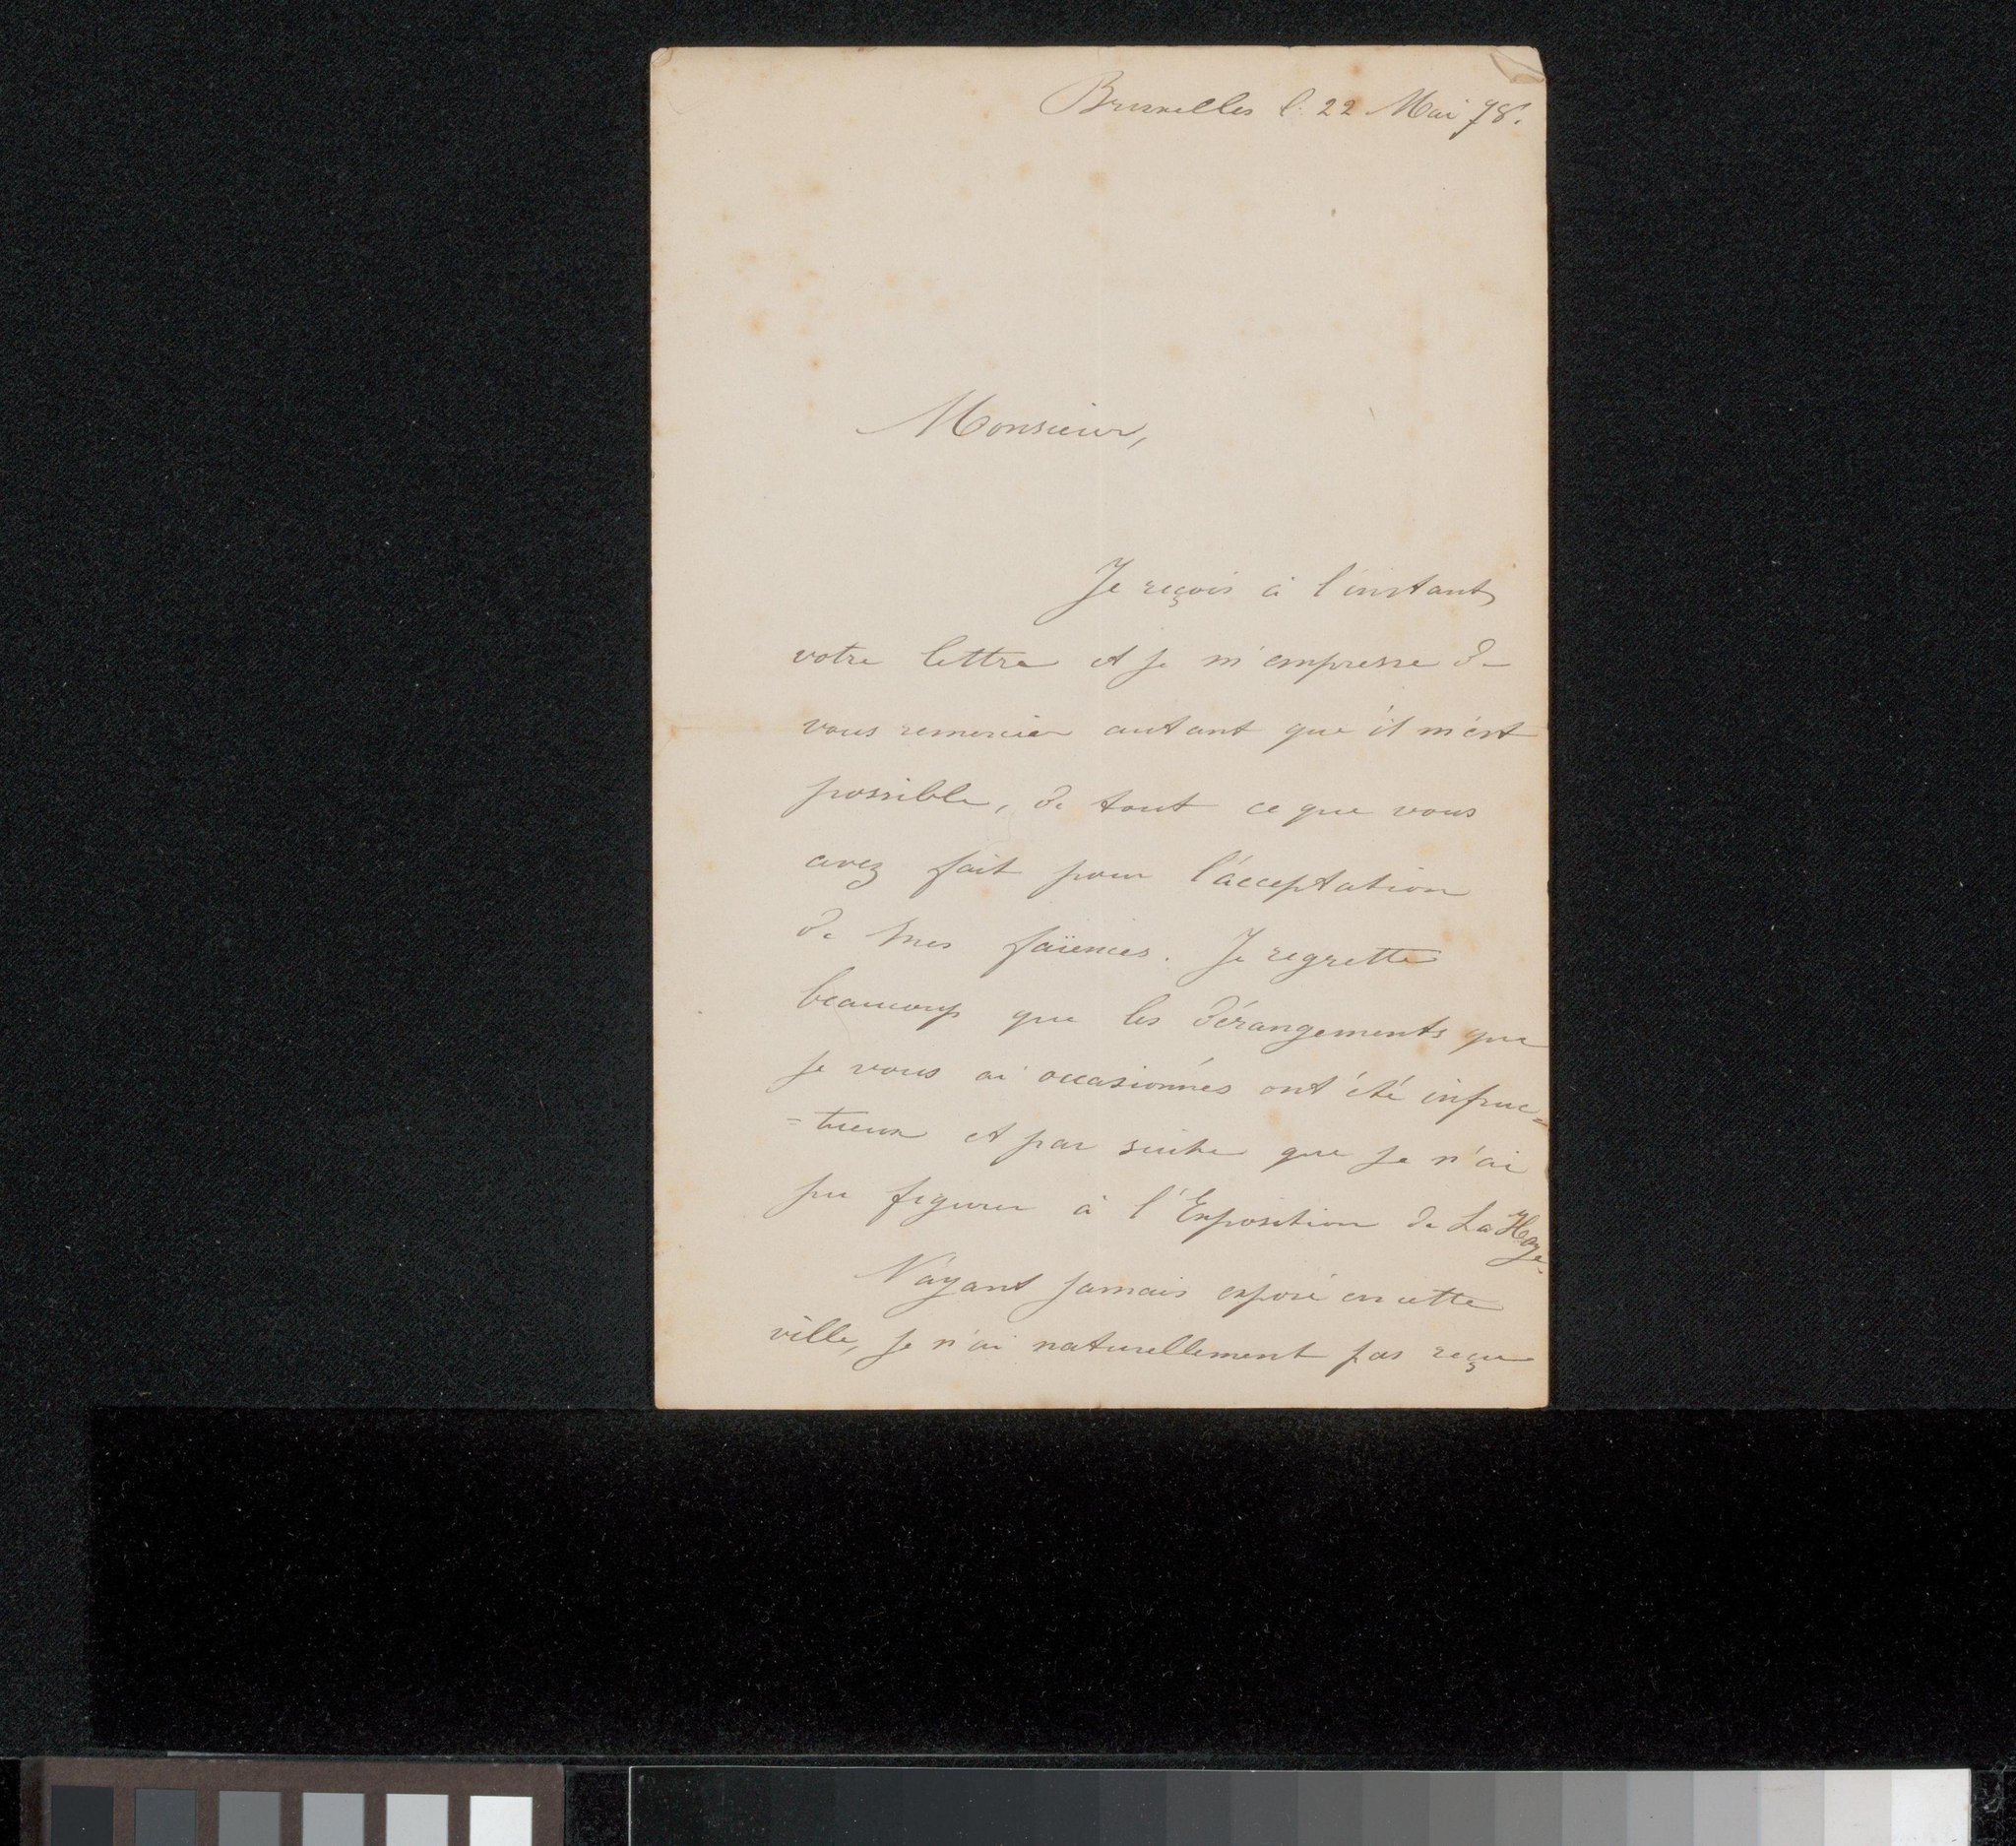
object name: letter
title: Brief aan Philip Zilcken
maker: georgette meunier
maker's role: painter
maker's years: 1859-1951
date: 1878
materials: ink, paper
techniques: pen, writing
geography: brussels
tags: the hague, painter, draughtsman, philip zilcken, applied arts, arts and crafts; industrial design, exhibition ~ art, brussels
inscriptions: collector's mark: ‘RPK’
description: RP-D-1982-43-MEUNIER(G.)-3B vormt een bijlage bij deze brief.